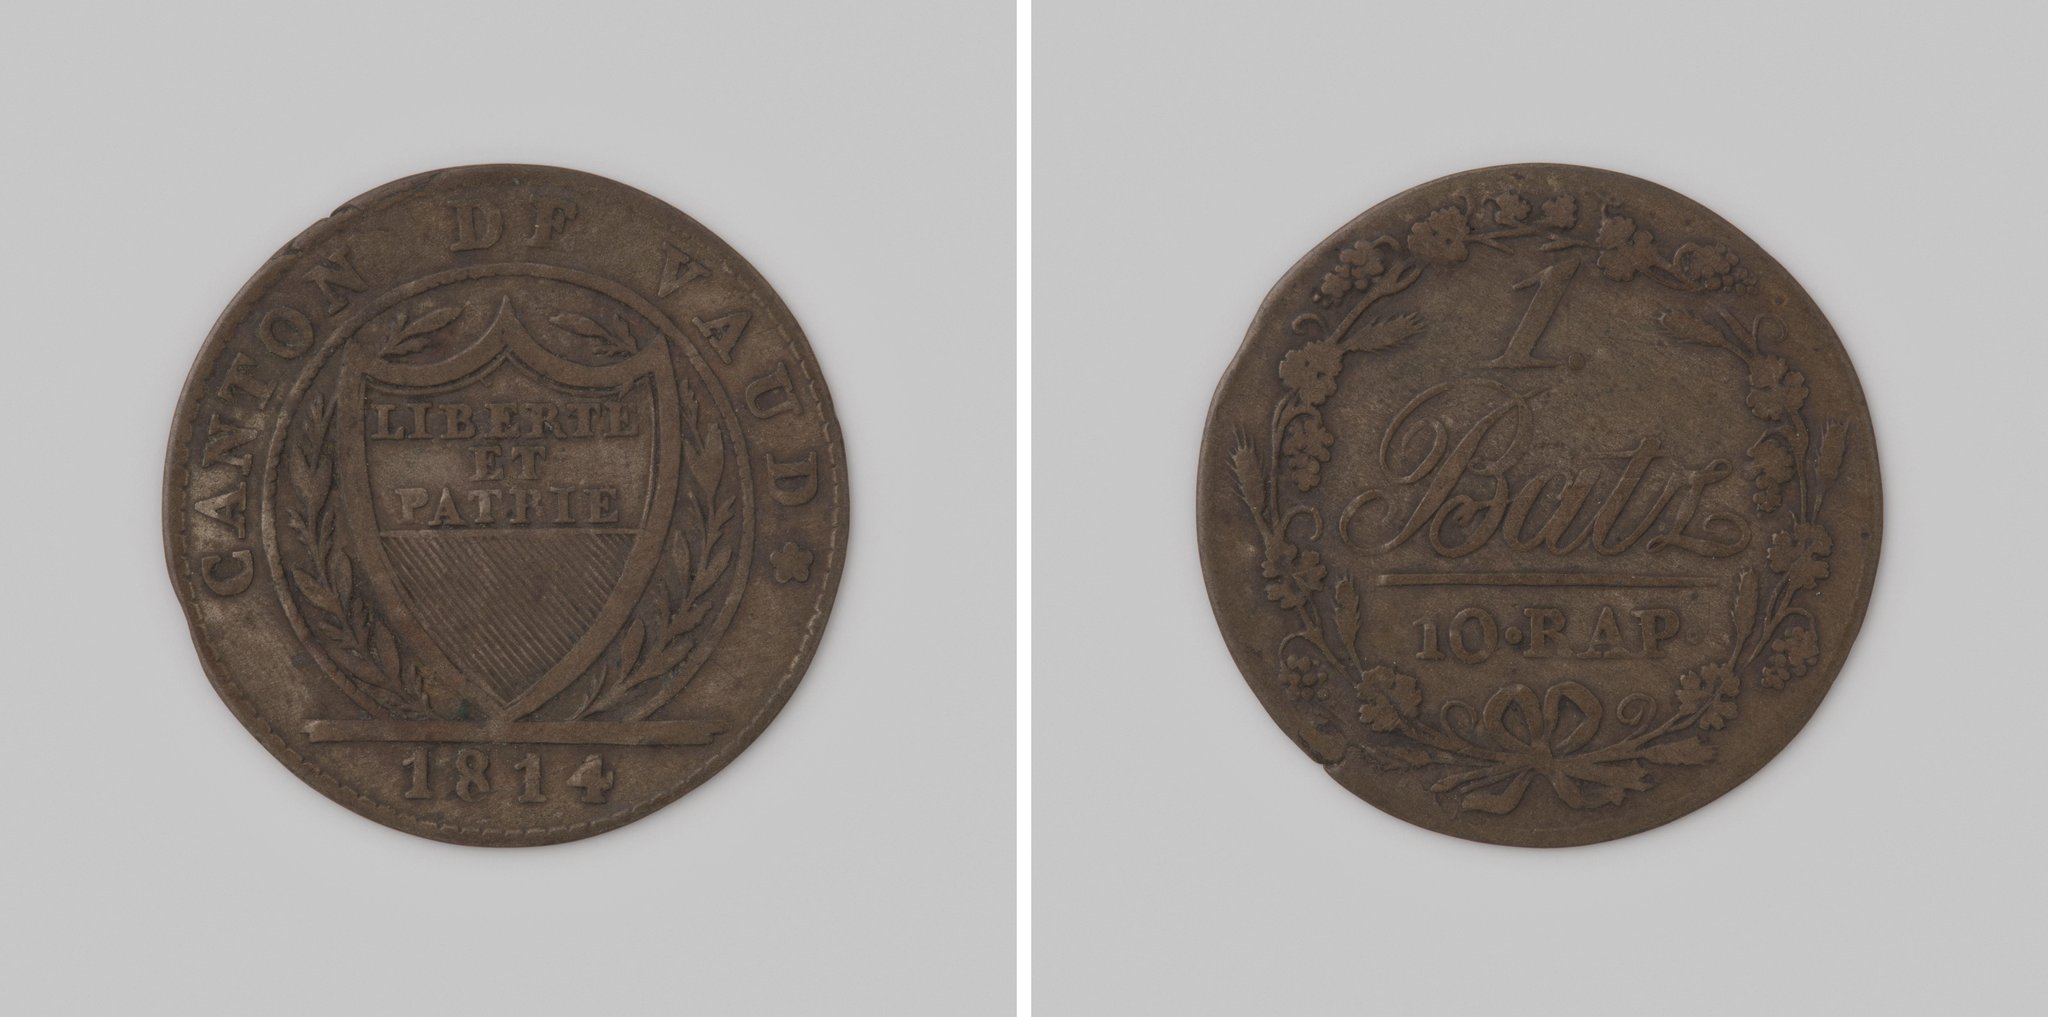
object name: coin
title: Batz of 10 rappe uit het kanton Vaud, 1814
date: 1814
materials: silver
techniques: striking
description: Zilveren munt. Voorzijde: tussen twee samengebonden takken wapenschild. In afsnede jaartal. Keerzijde: binnen twee samengebonden takken waarde-aanduidingen in drie regels. Gladde rand.